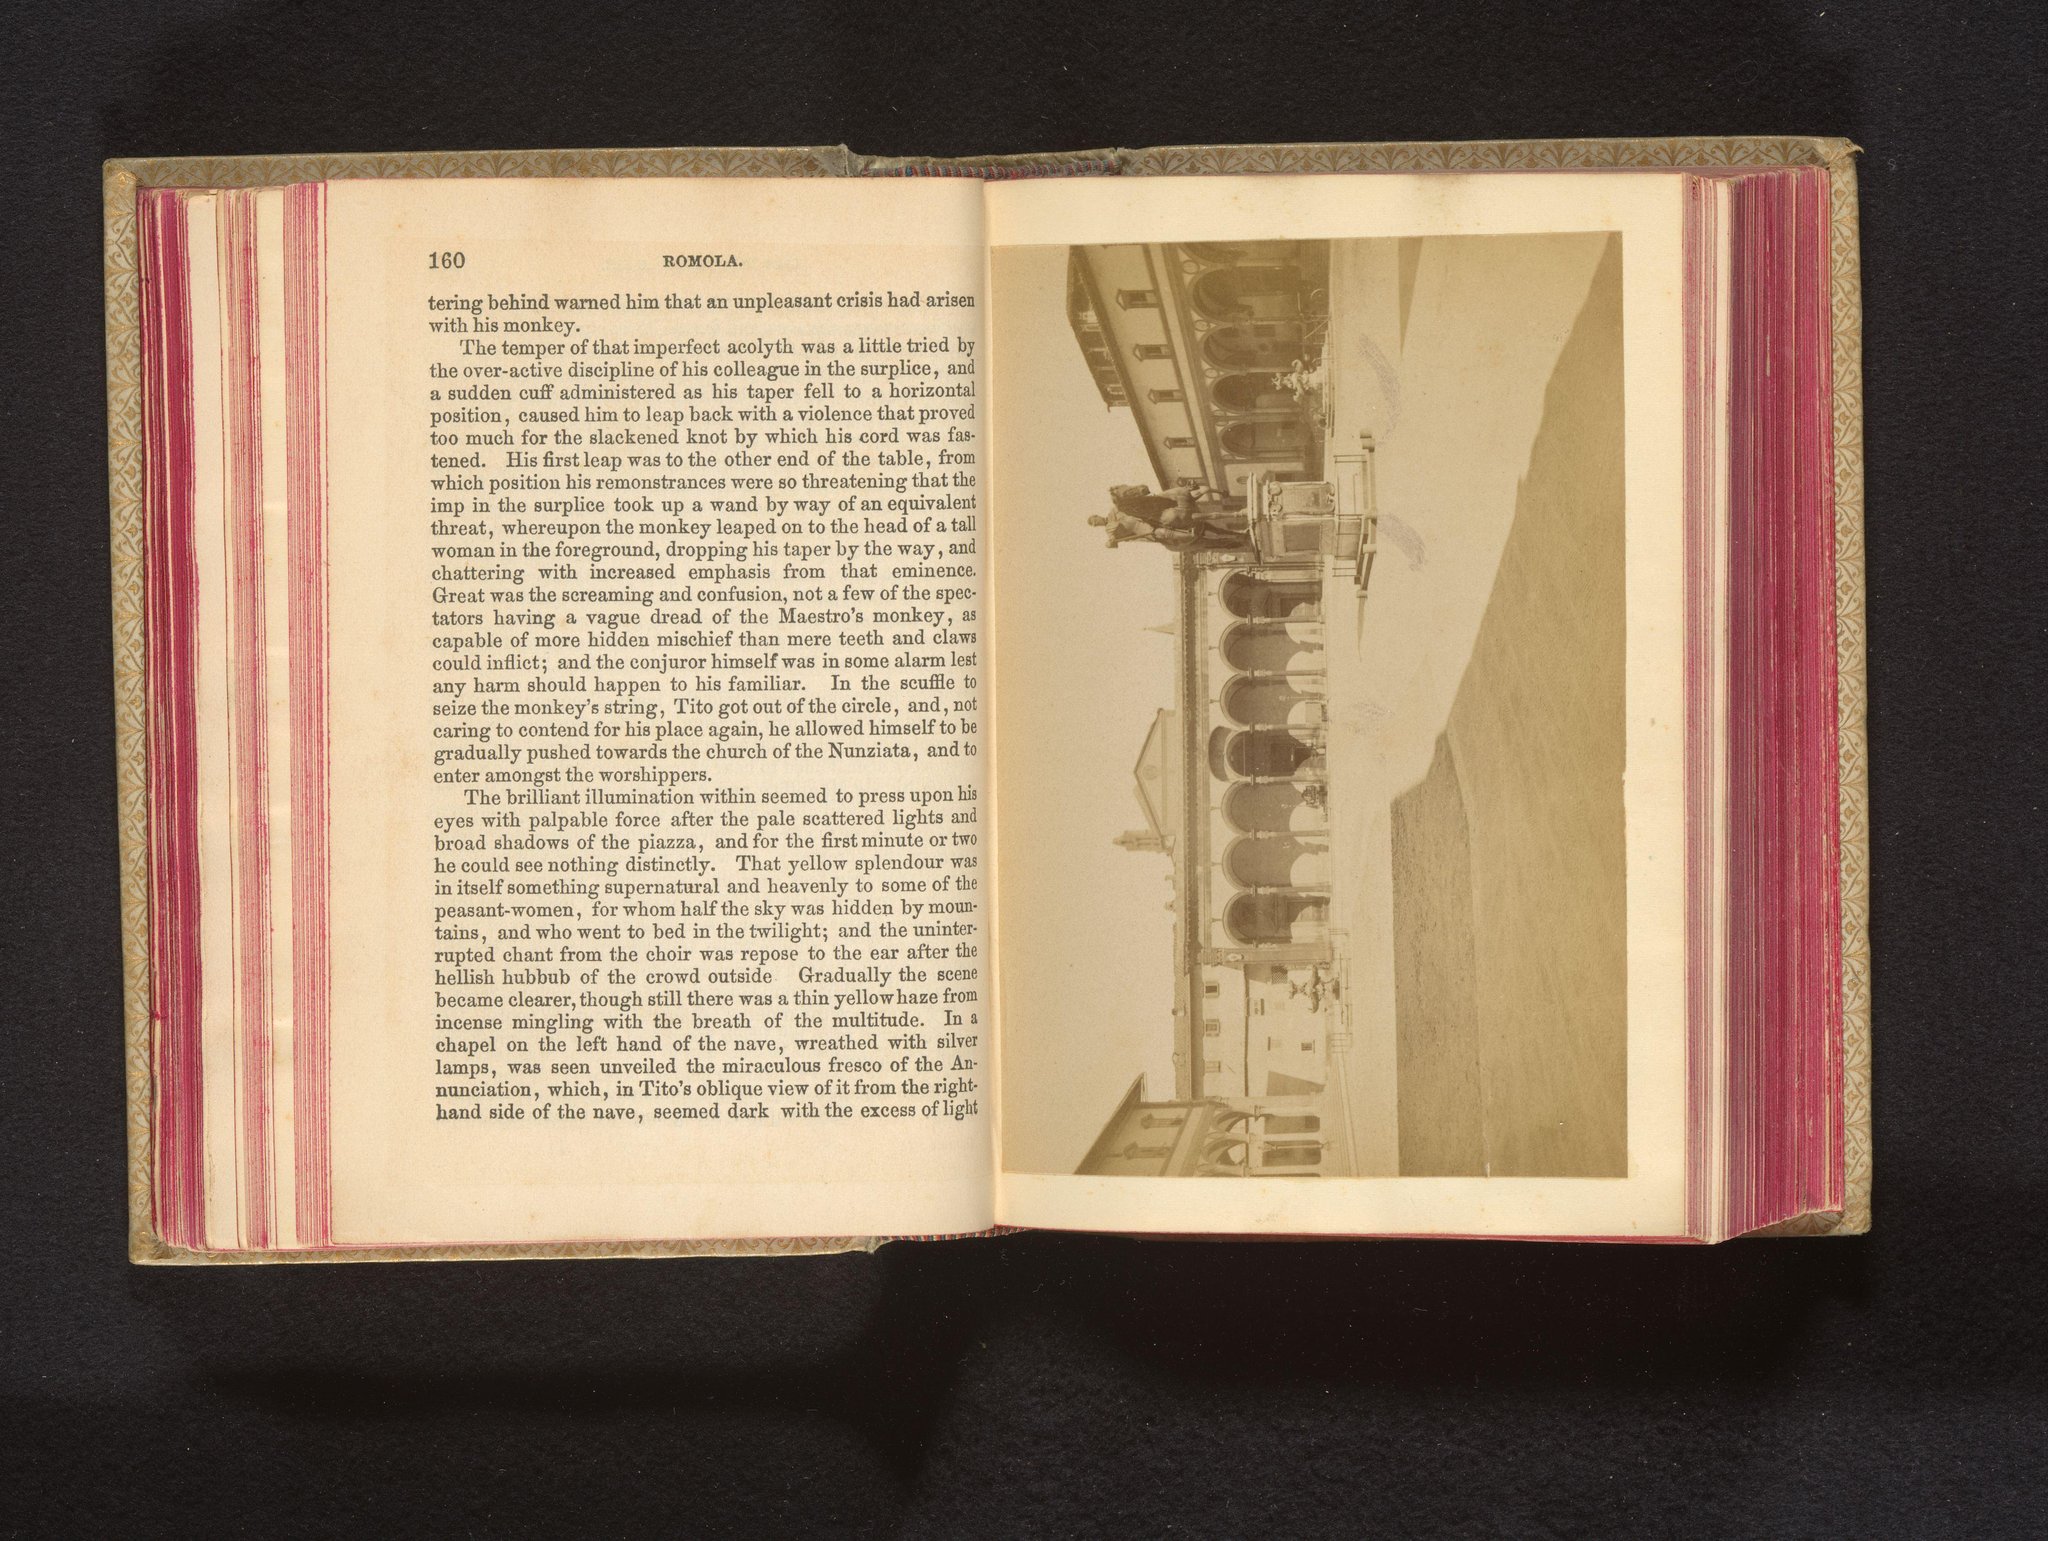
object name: page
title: Zuilengang van het Ospedale degli Innocenti te Florence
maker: Anonymous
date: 1858-1863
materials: photographic support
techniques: albumen print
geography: florence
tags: foundling-hospital, façade (of house or building)